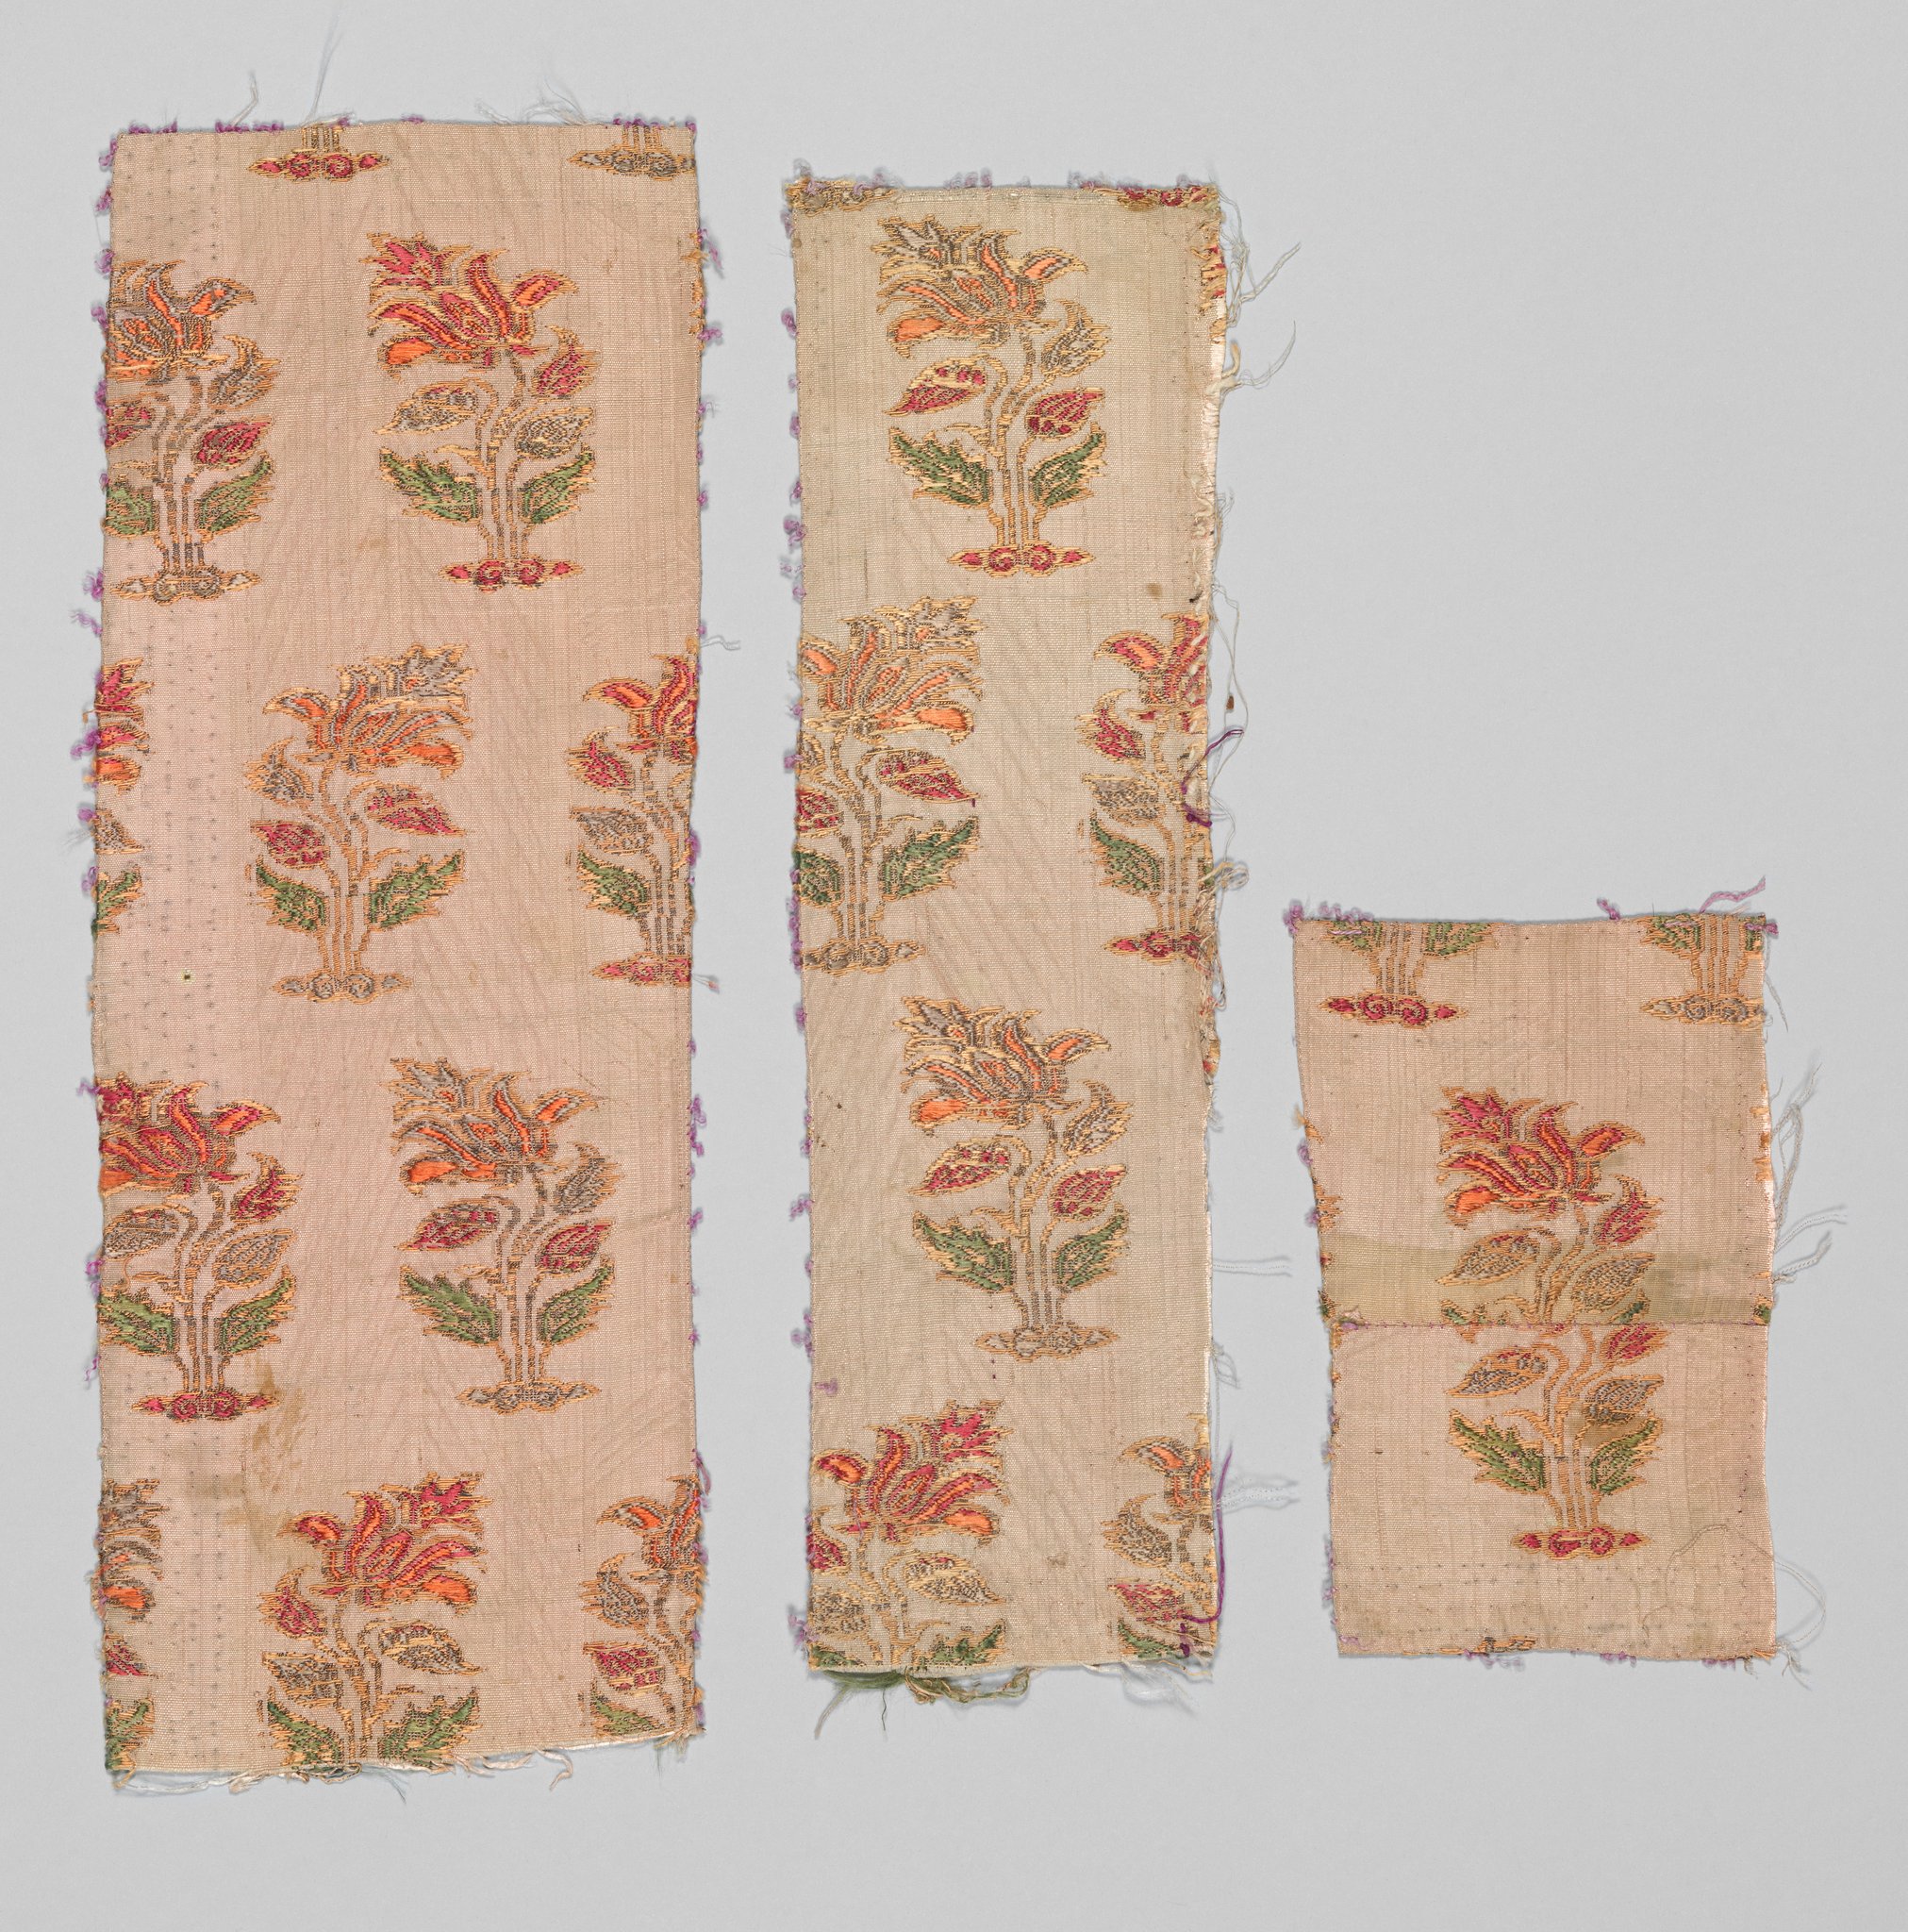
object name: textile fragment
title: Three Textile Fragments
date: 1700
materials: metal thread, silk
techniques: brocade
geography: india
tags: flowers